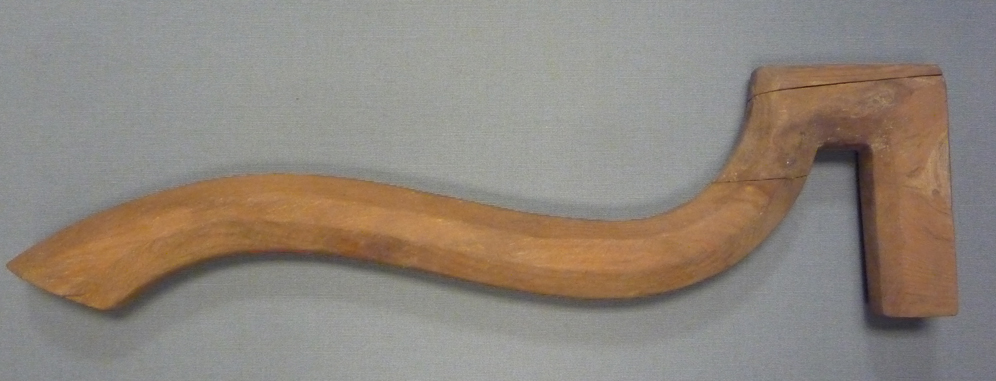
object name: tool, mesekhetyu, hatshepsut foundation deposit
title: Ritual tool for the "Opening of the Mouth" ceremony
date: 1479-1458 BCE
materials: wood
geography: egypt